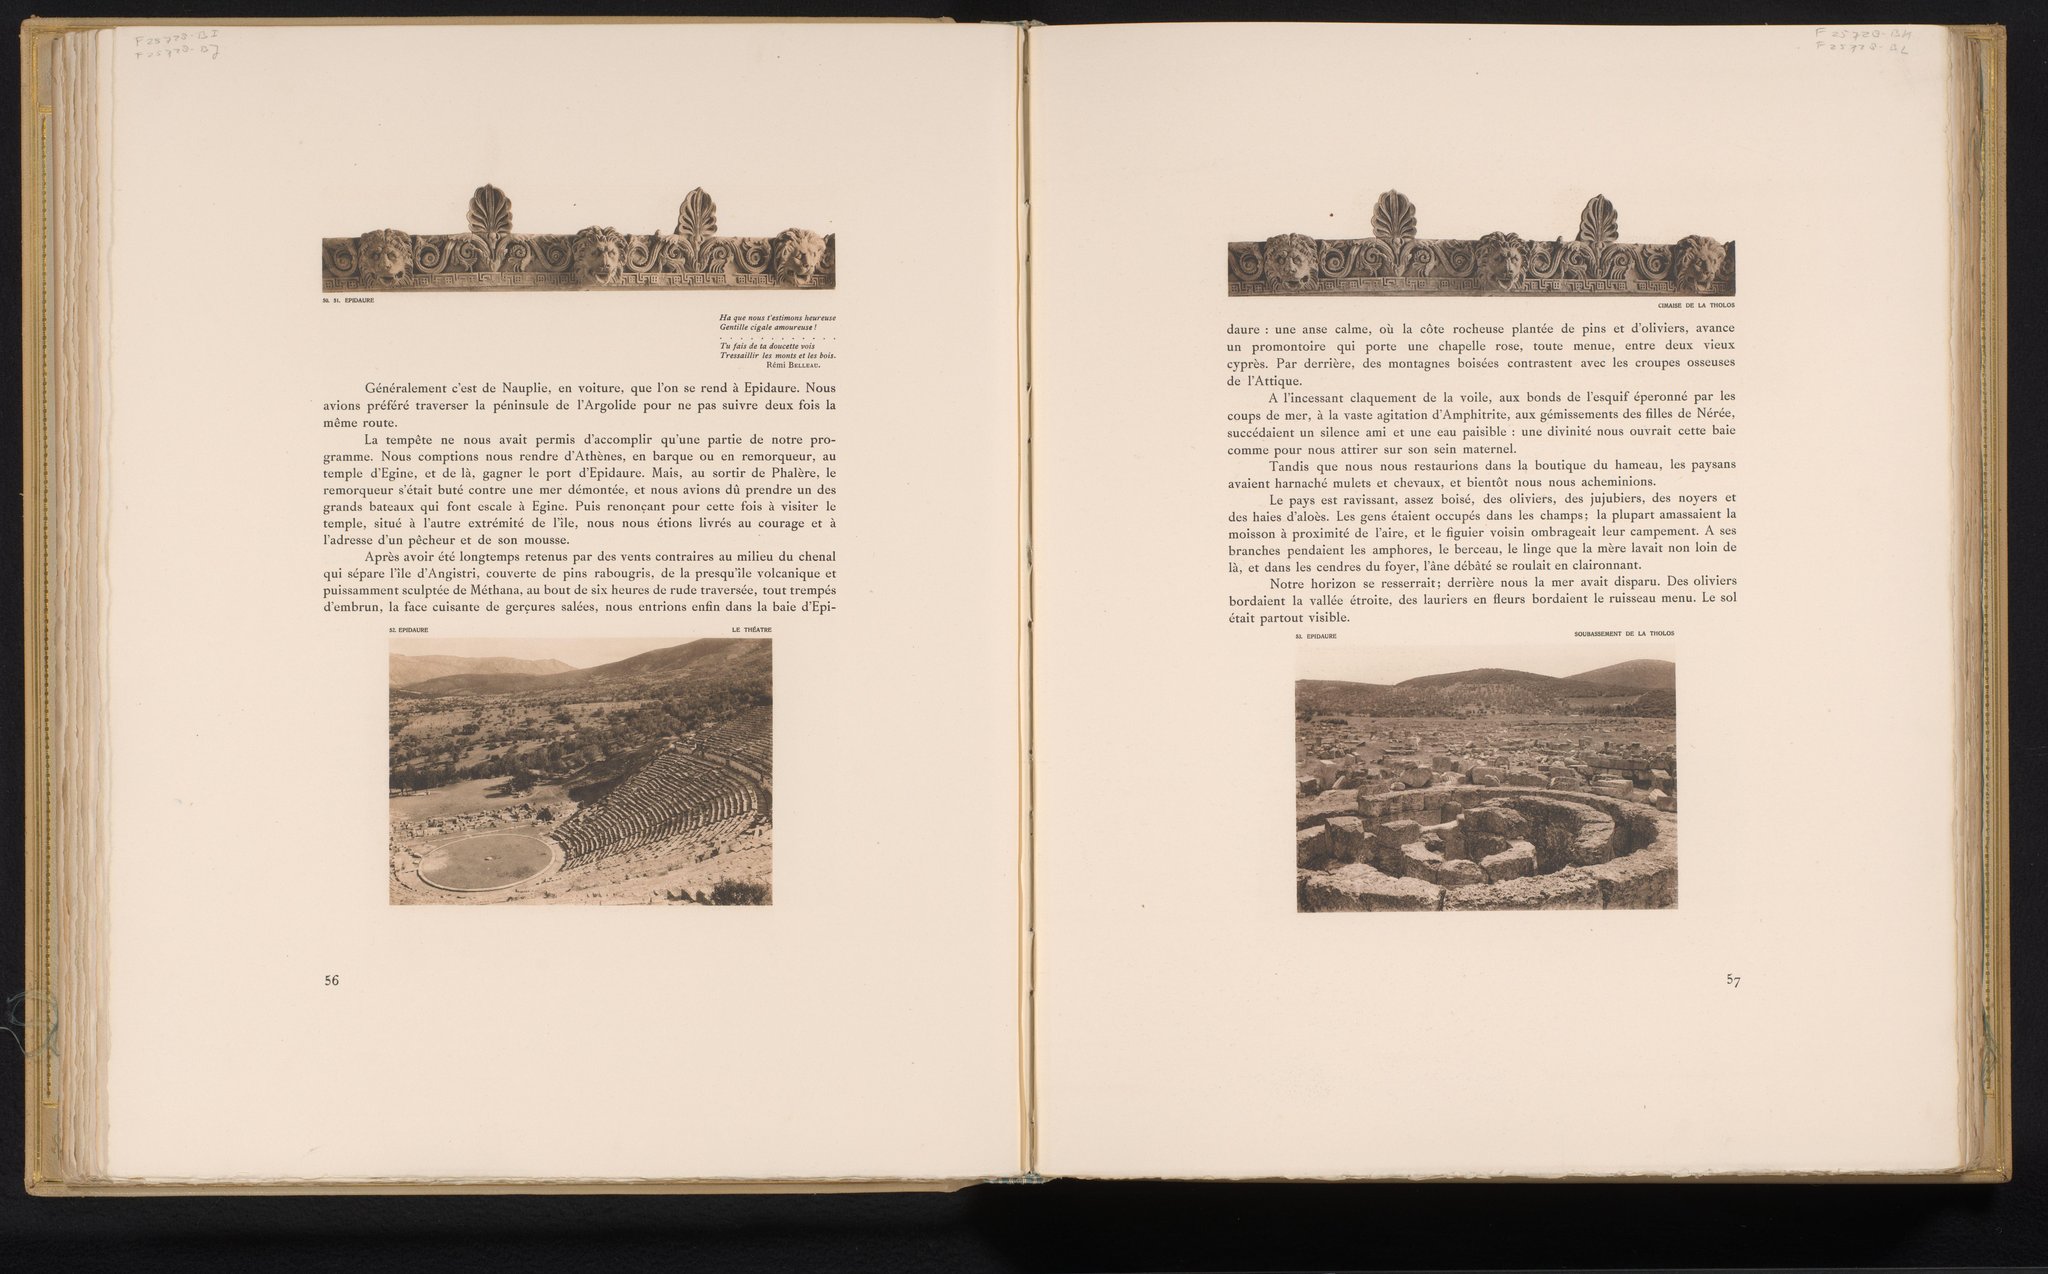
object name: photomechanical print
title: Versieringen van de tholos van Epidaurus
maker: frédéric boissonnas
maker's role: fotograaf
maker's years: 1858-1946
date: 1905-1910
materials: paper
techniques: photograph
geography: berlin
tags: sculpture